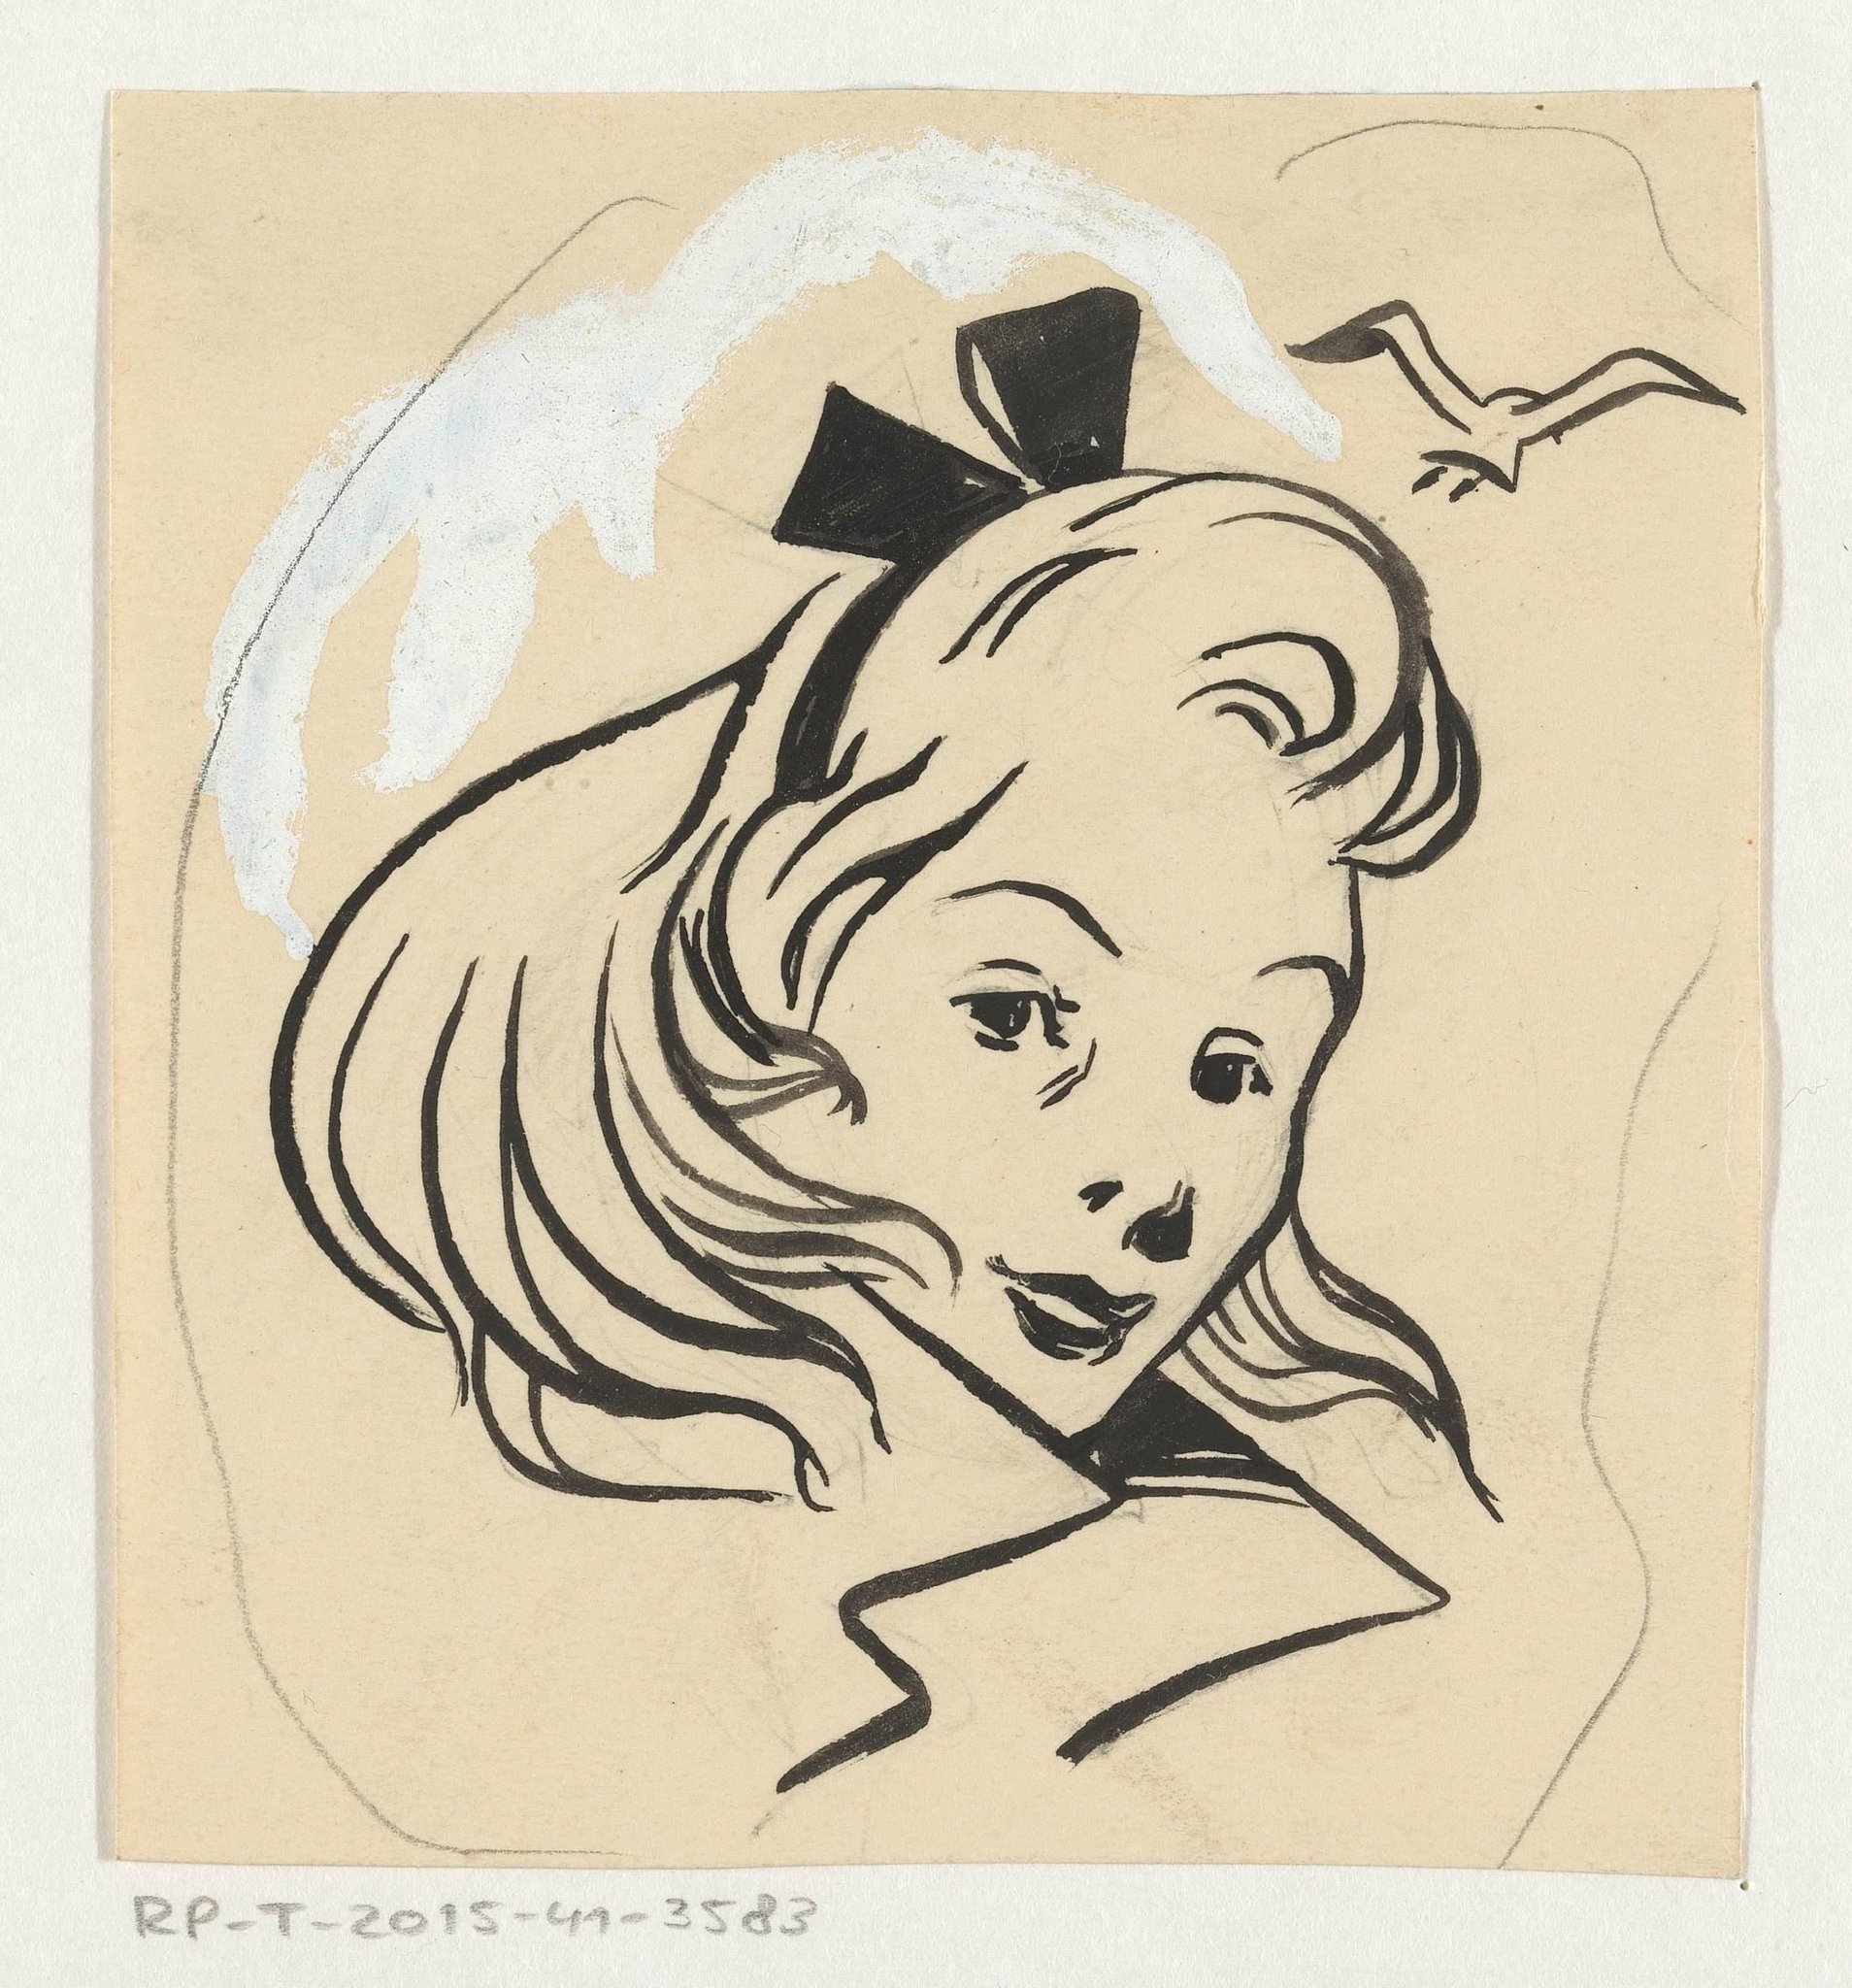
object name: boekillustratie ontwerp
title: Meisje met strik in het haar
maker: Anonymous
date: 1910-1940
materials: paint, ink, paper, pencil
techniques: brush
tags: adolescent, young woman, maiden, birds